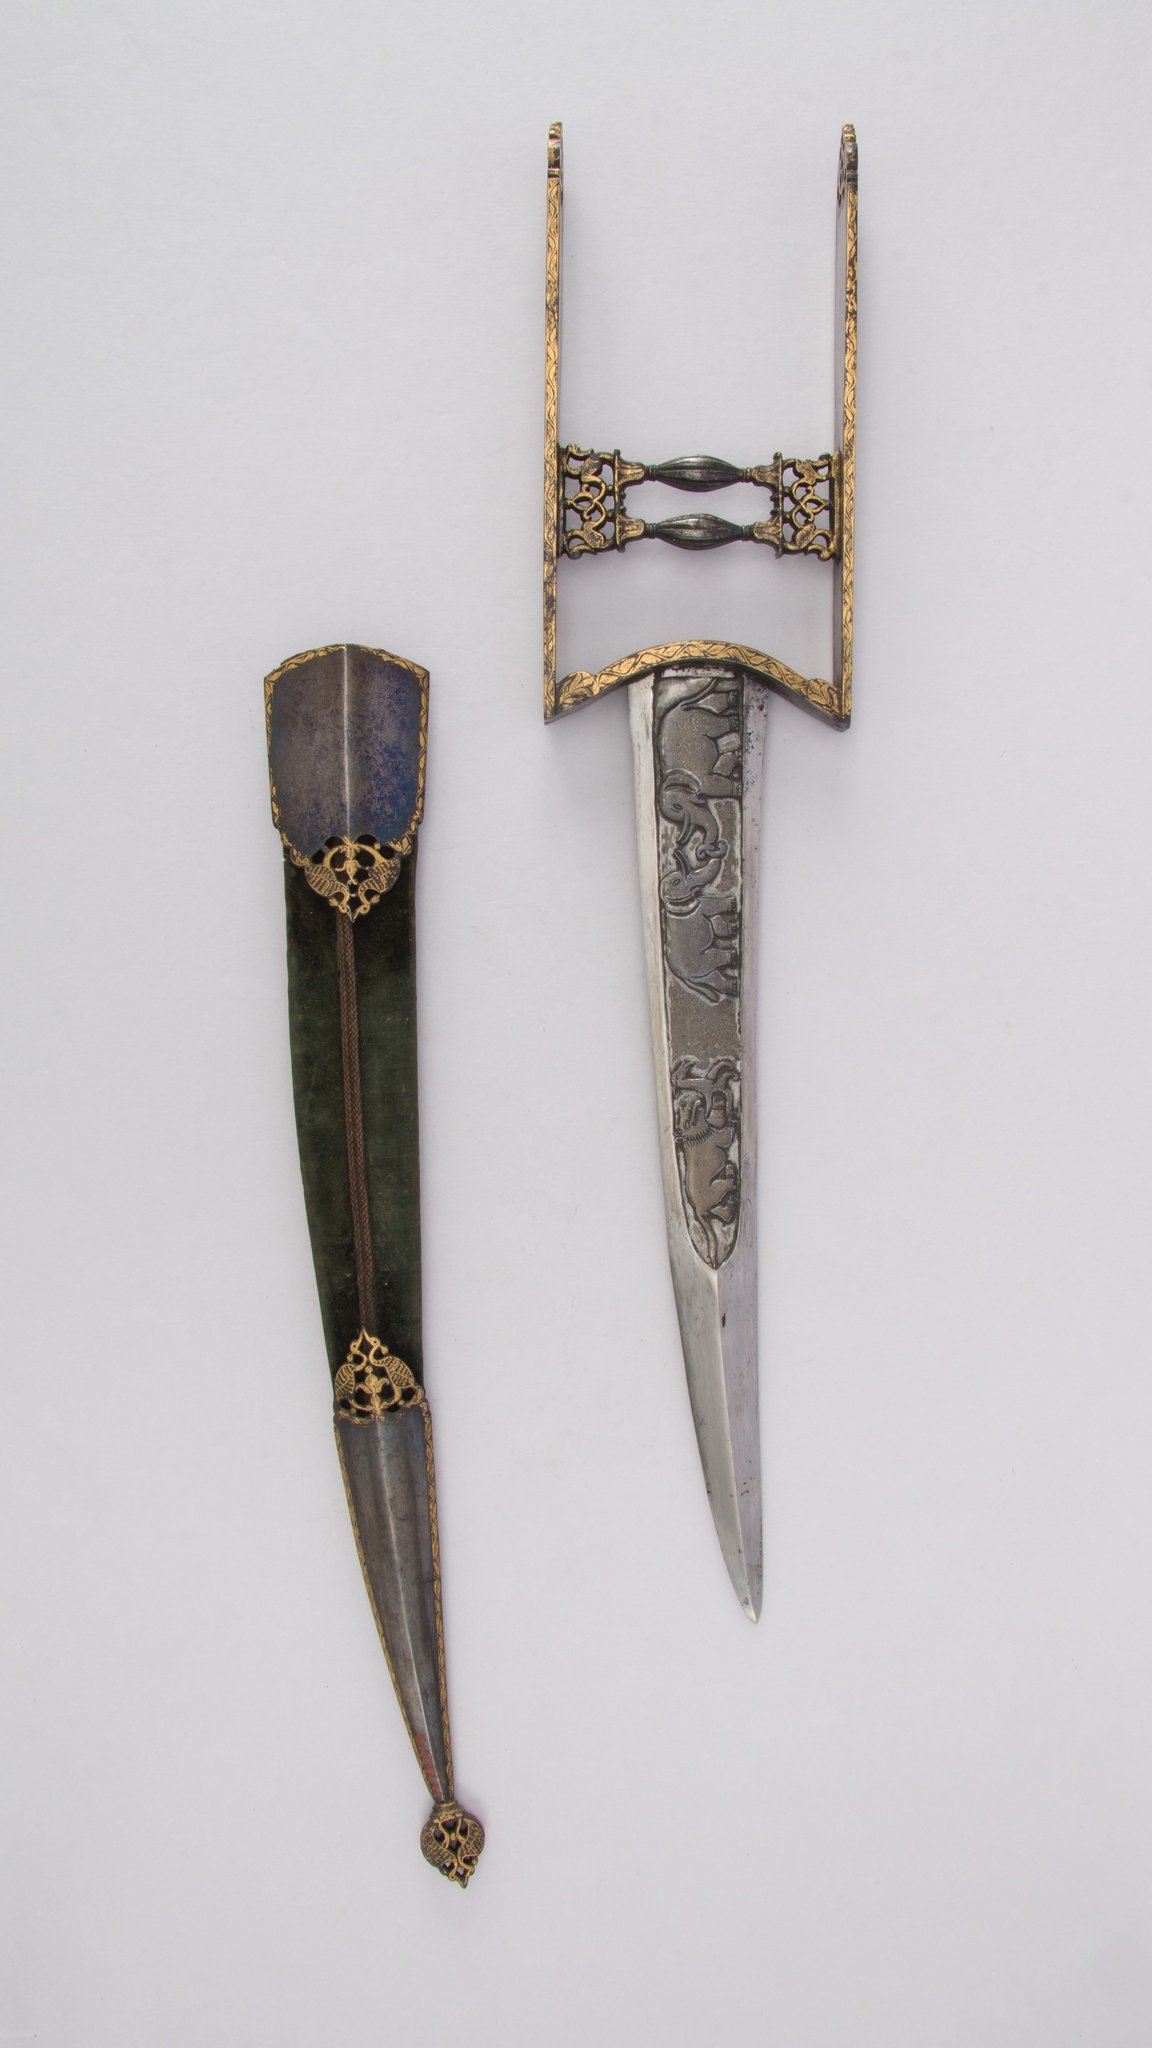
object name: dagger with sheath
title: Dagger (Katar) with Sheath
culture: north indian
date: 1701-1800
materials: gold, steel, velvet, wood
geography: india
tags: animals,elephants